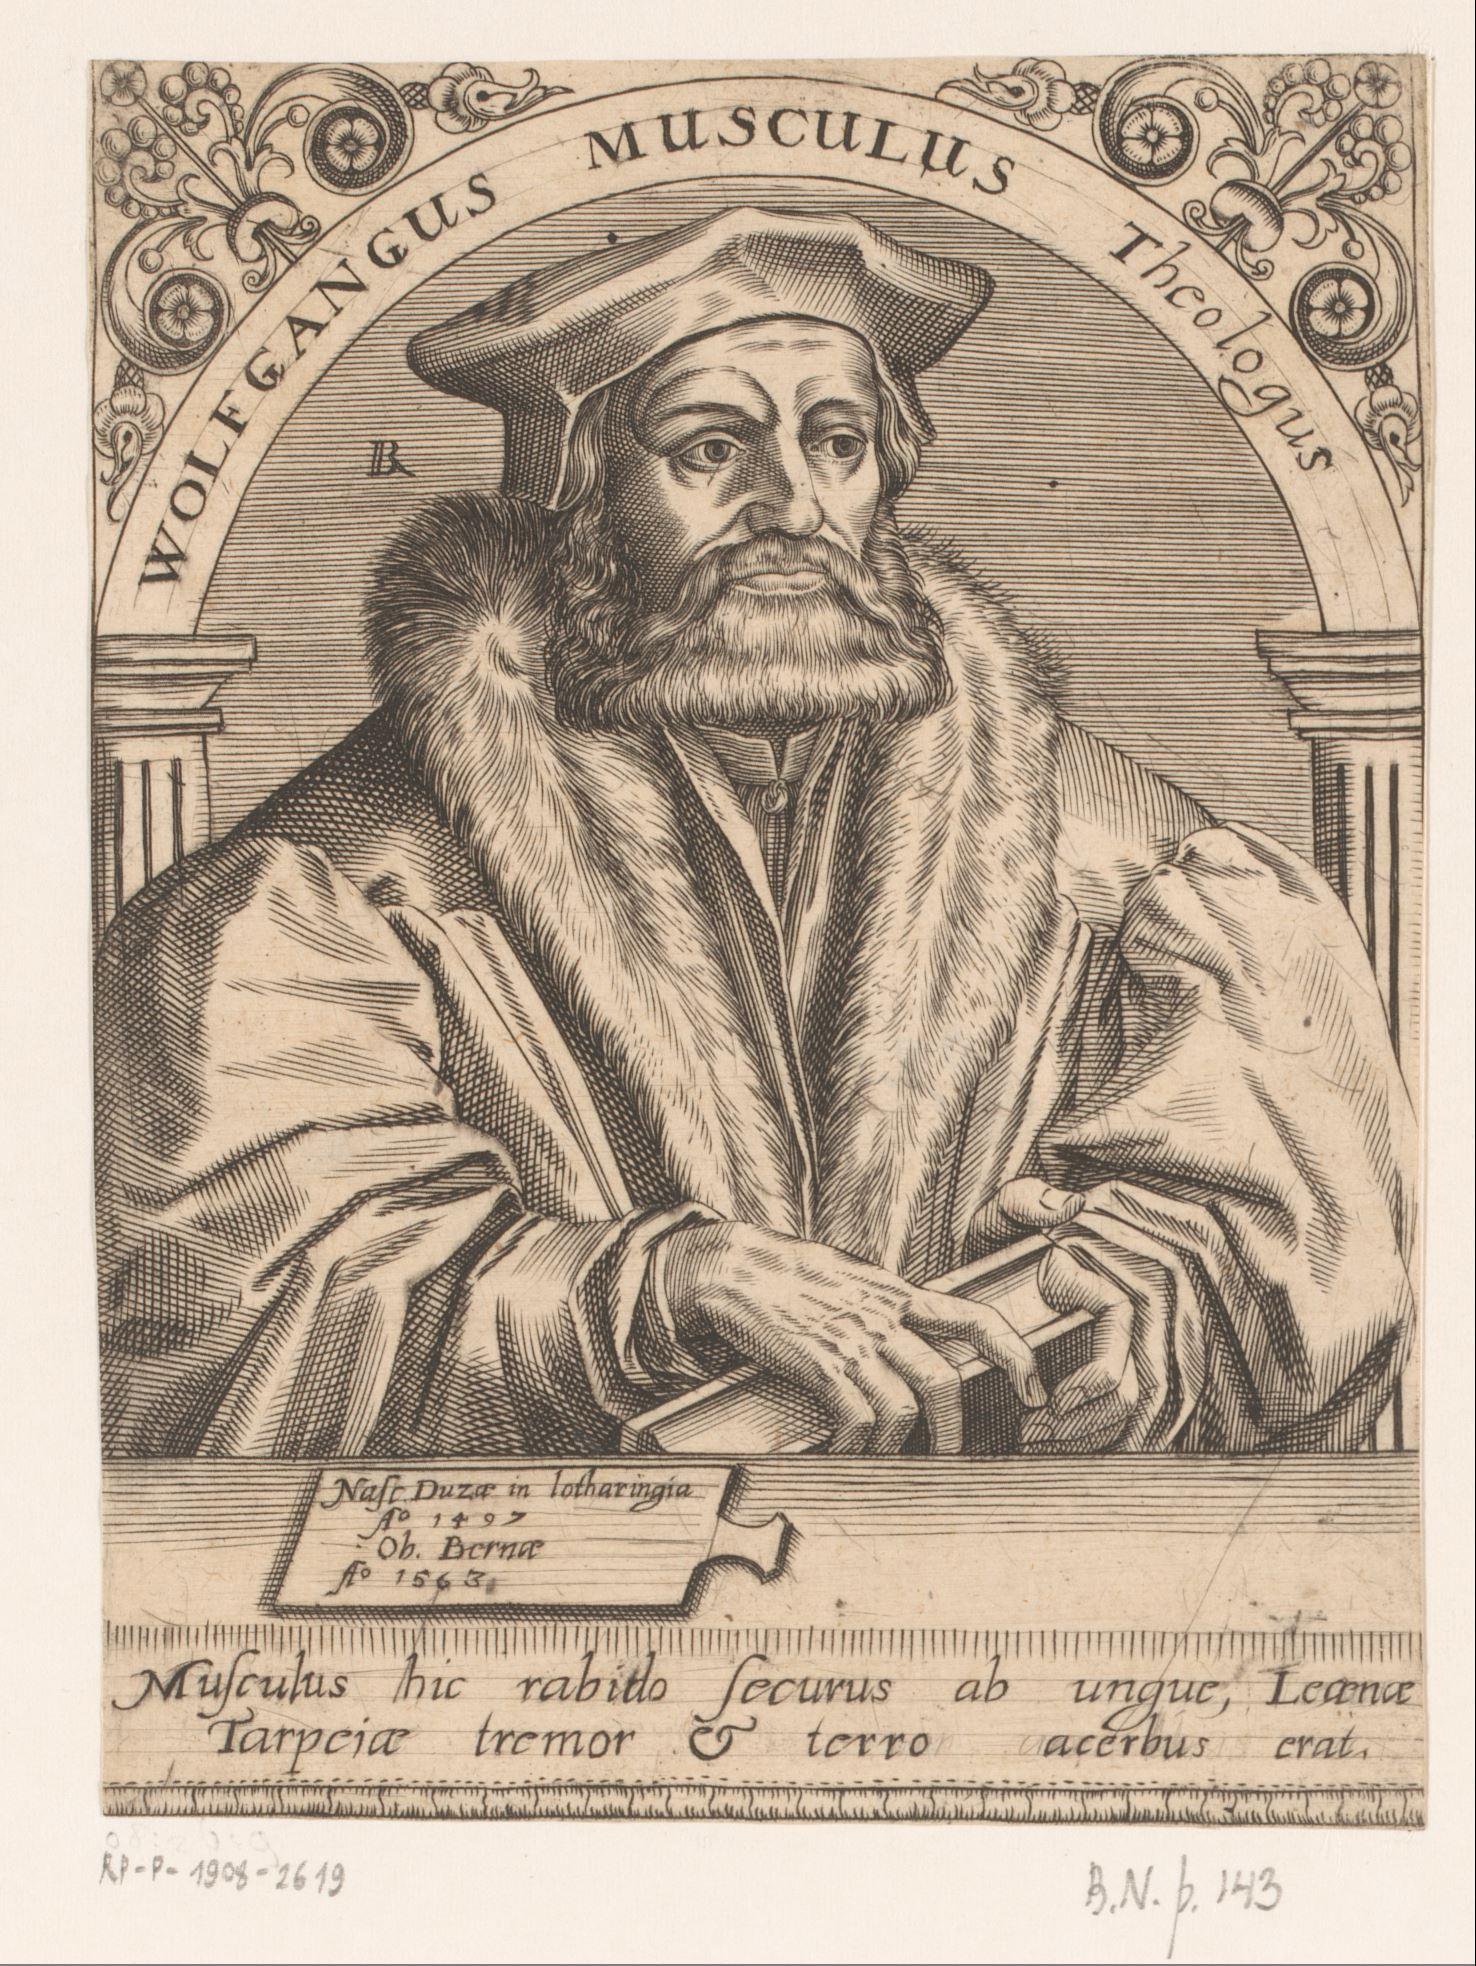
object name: print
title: Serie portretten van vijftiende- en zestiende-eeuwse geleerden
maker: robert boissard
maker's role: print maker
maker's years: 1570-1611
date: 1597-1599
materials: paper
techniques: engraving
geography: france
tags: historical persons, book